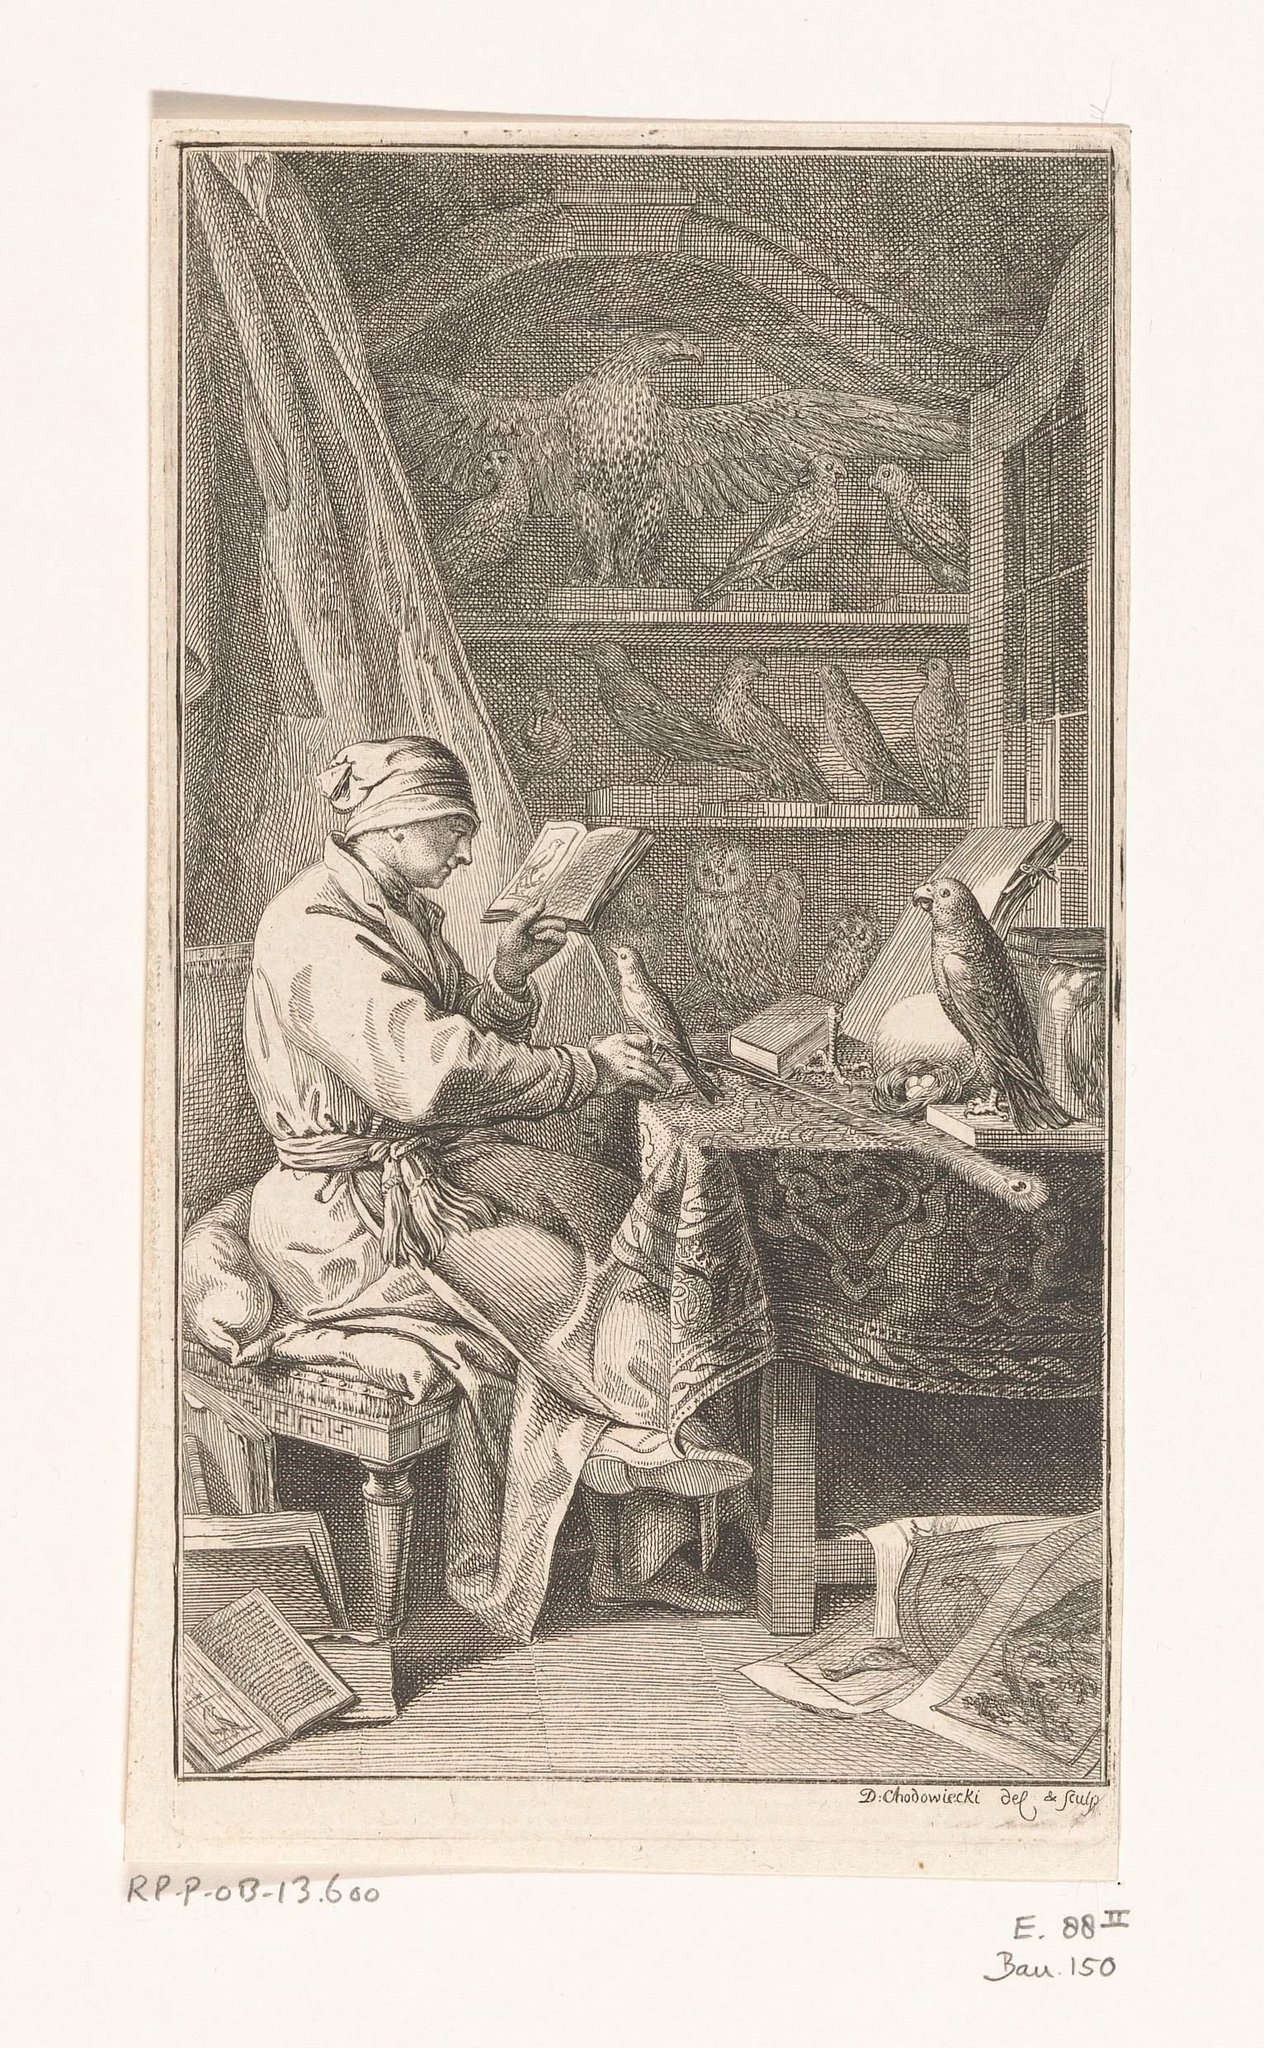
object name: print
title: Ornitholoog in zijn studeerkamer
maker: daniel nikolaus chodowiecki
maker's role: draughtsman, print maker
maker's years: 1726-1801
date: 1772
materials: paper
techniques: etching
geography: berlin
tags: scholar in his study, birds, print, e.g.: engraving, etching, lithograph, cabinet of curiosities, 'kunst- und wunderkammer'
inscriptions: collector's mark: Lugt 240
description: Prent ook gebruikt in: Buffon, Georges-Louis Leclerc Comte de. Naturgeschichte der Vögel [vertaald door:] Friedrich Heinrich Wilhelm Martini. Berlijn: Joachim Pauli, 1772, dl. 1.